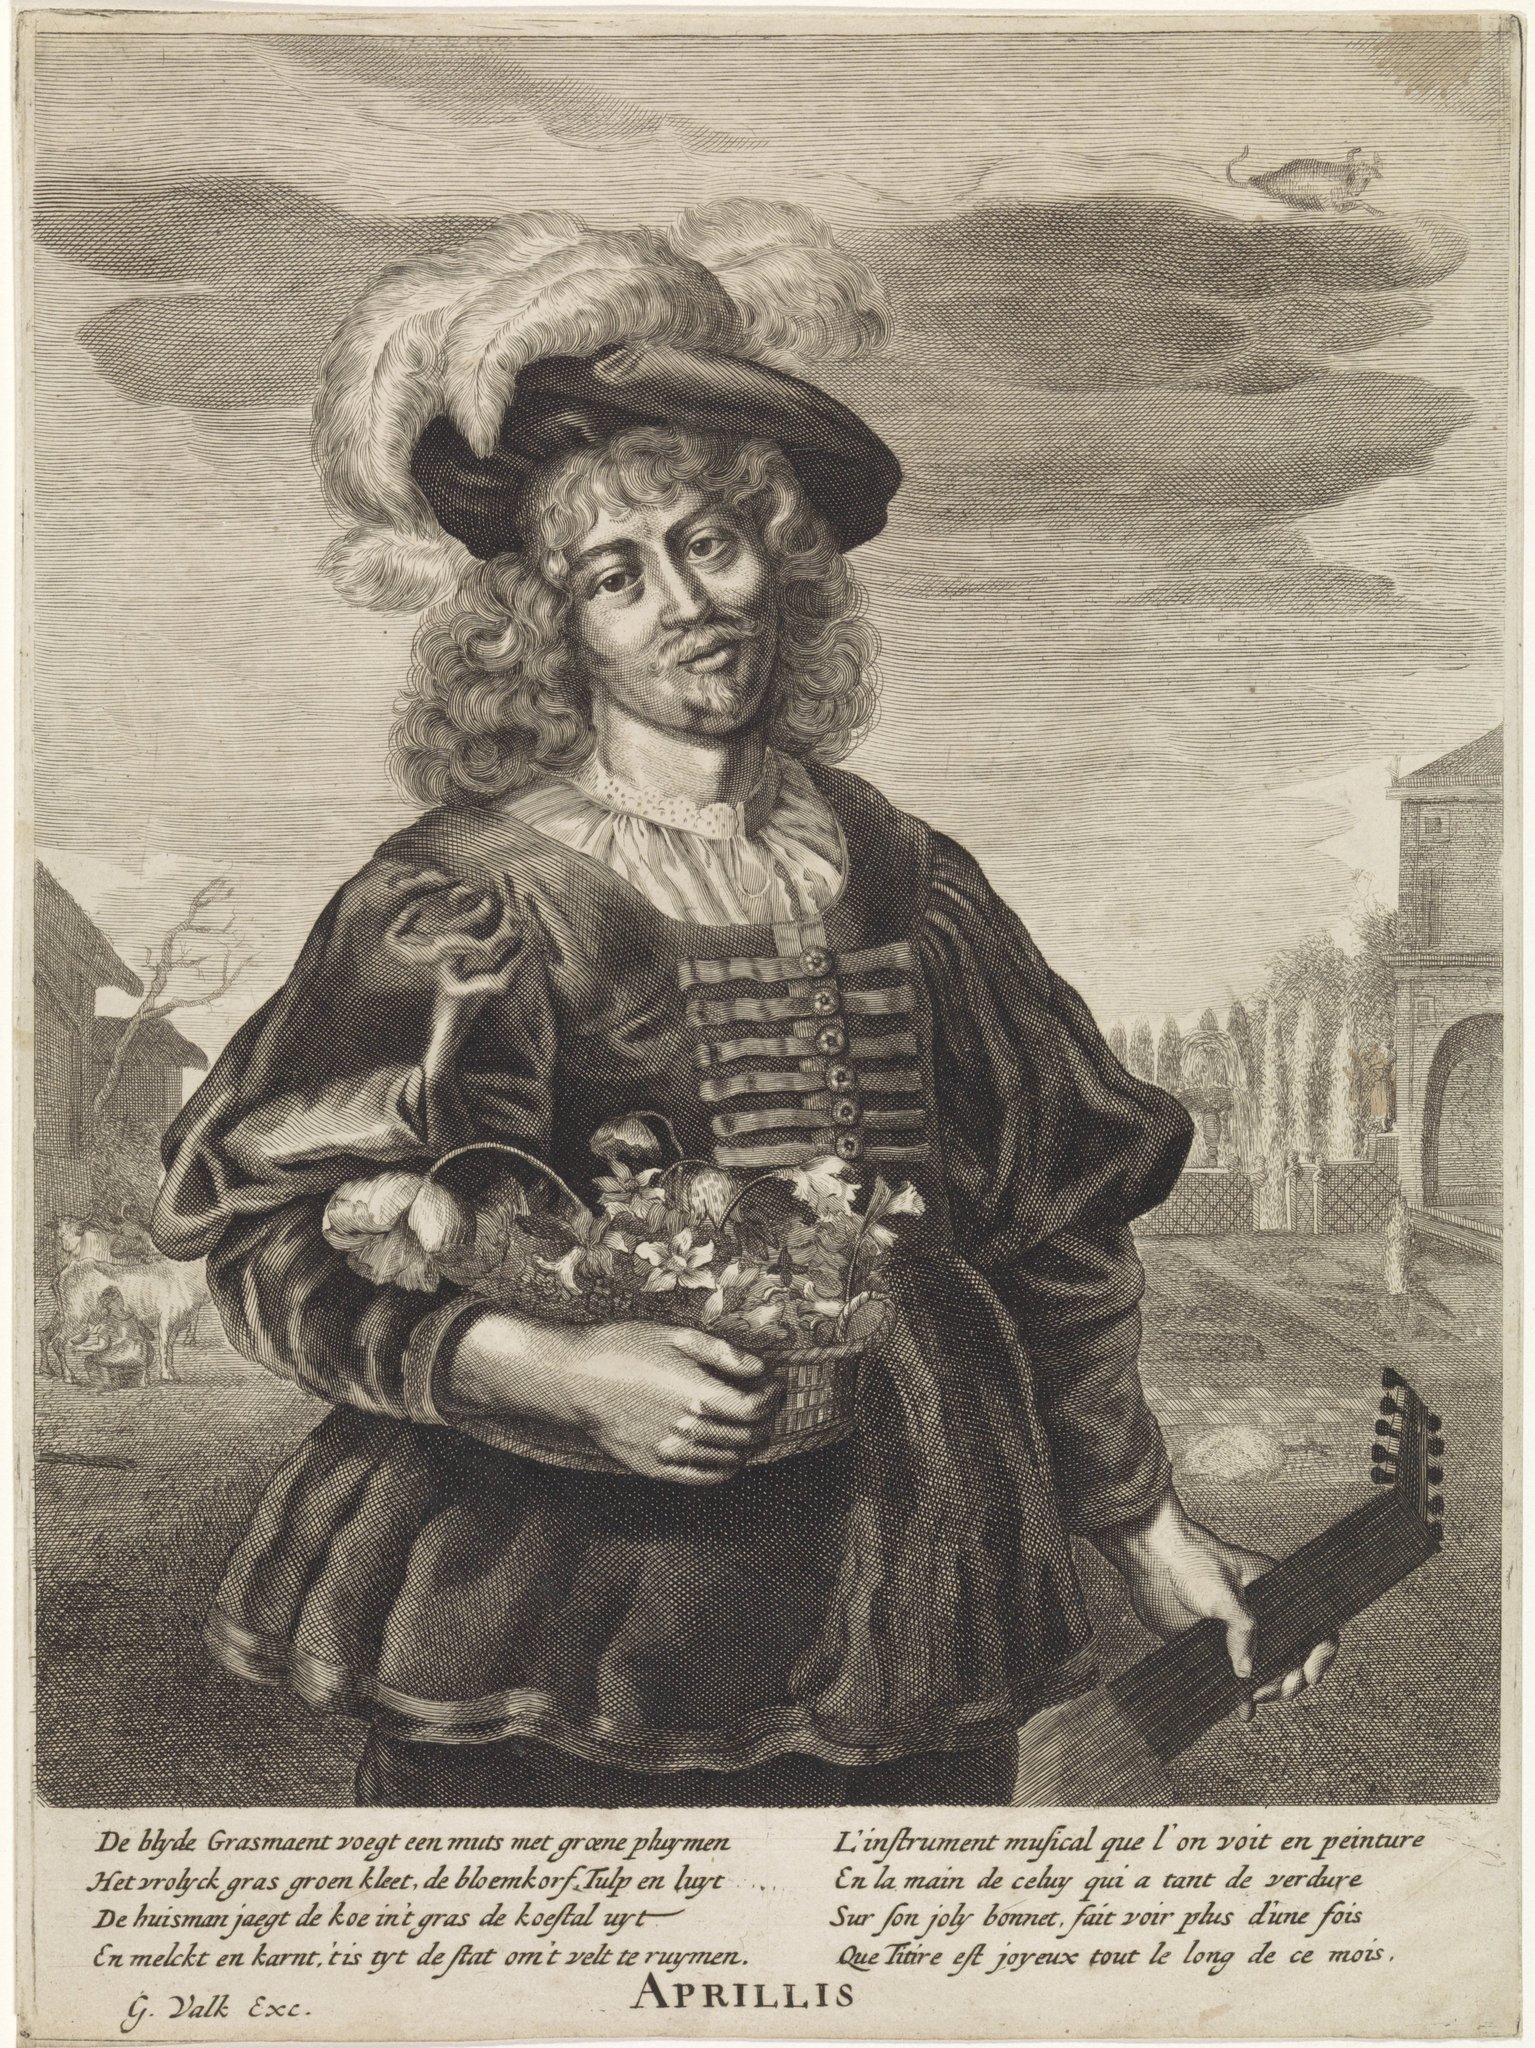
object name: print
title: Aprilis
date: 1670-1726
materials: paper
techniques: engraving, etching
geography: amsterdam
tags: april; 'aprile' (ripa) (+ with signs or personifications of the planets), april ~ other concepts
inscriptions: collector's mark: Lugt 2228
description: Een jongeman met een bloemenmand en een luit in de handen verbeeldt de maand april. Rechts een tuin en links een vrouw die een koe melkt. Op de wolken het sterrenbeeld stier. Onder de voorstelling een gedicht in het Nederlands van Joost van den Vondel en een vers in het Frans.